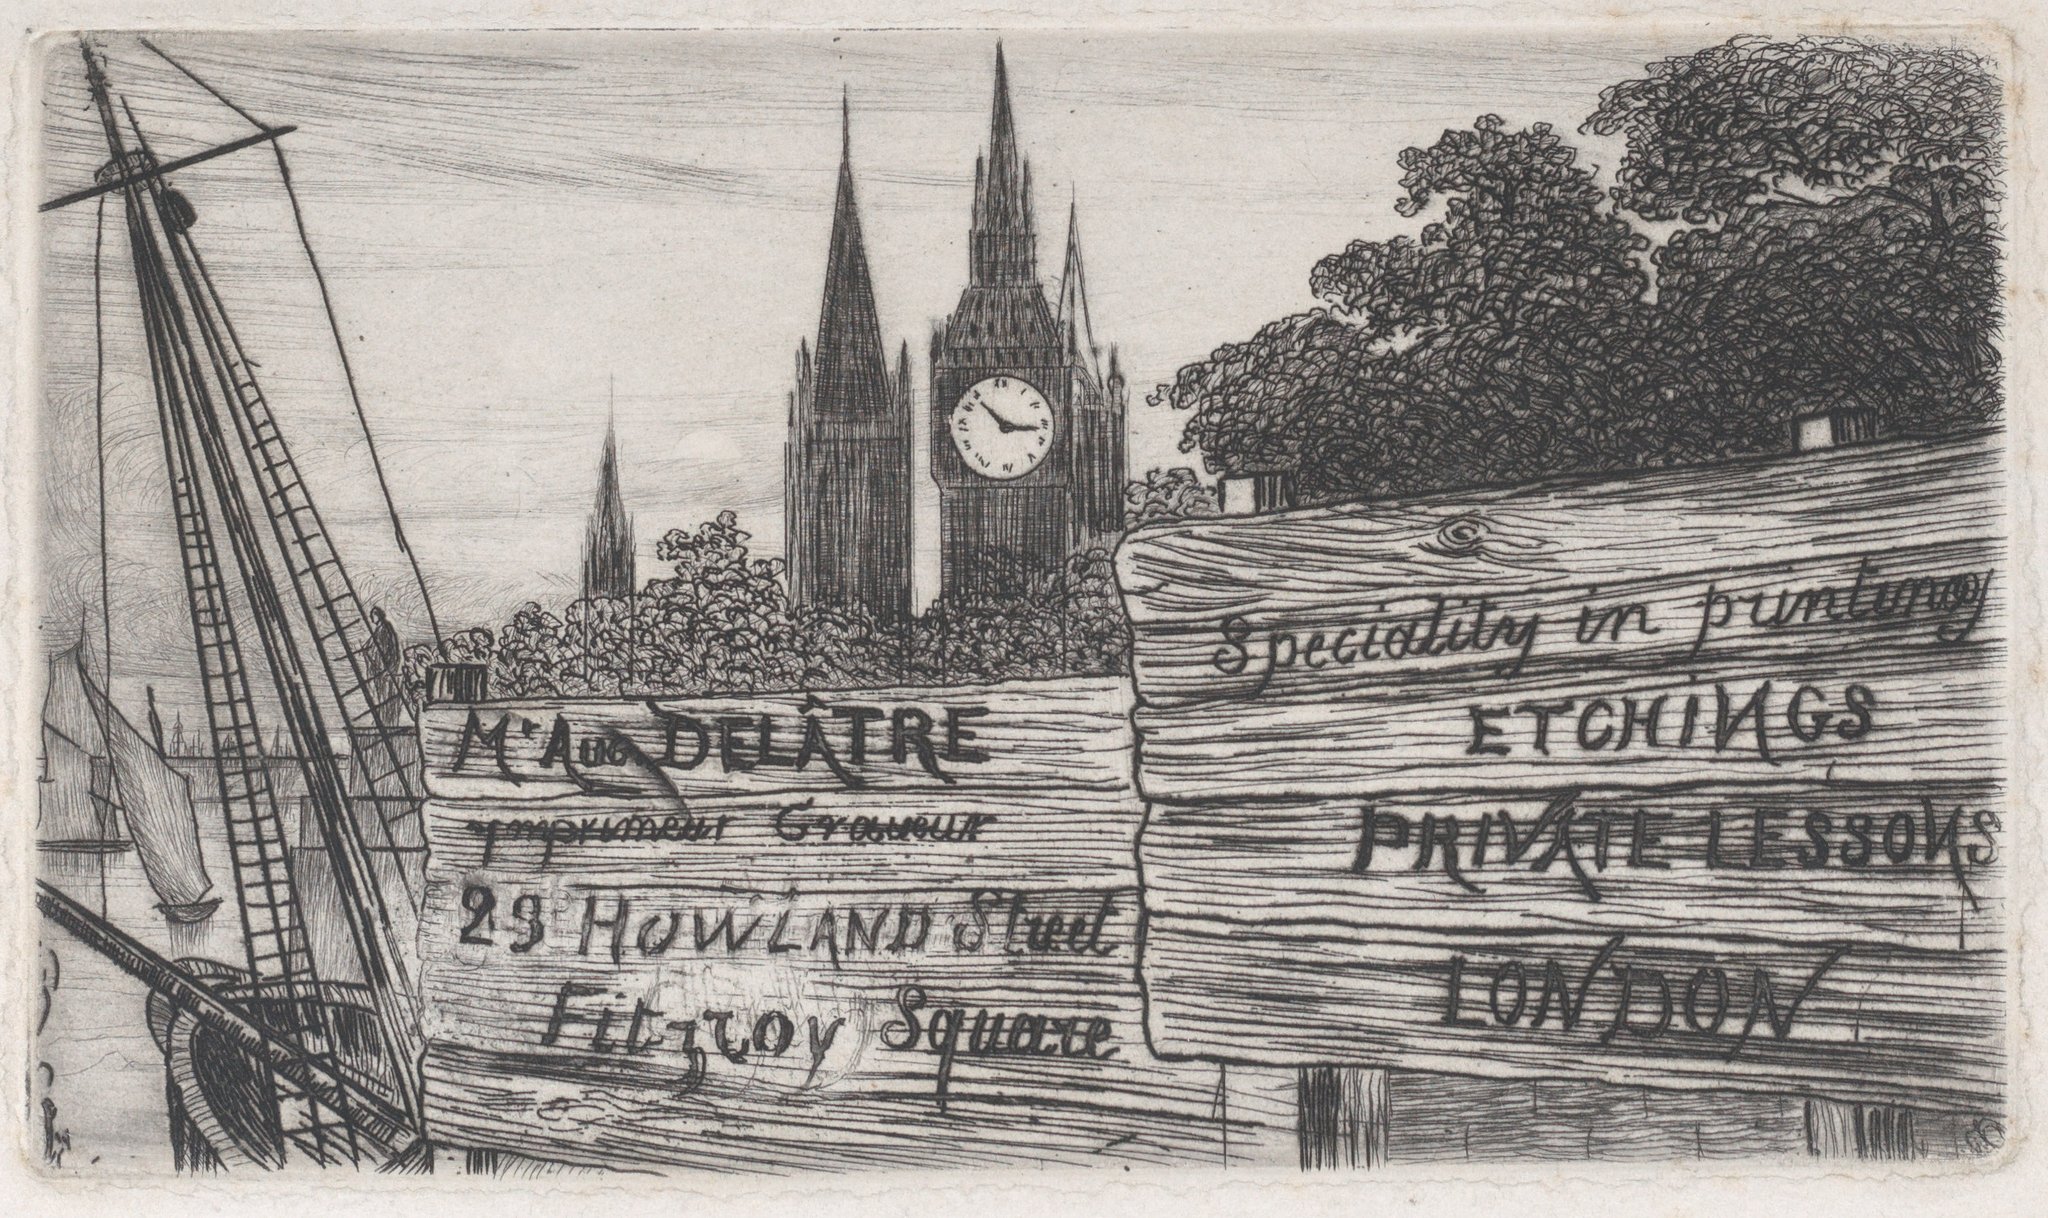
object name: print, trade card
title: Trade card for Auguste Delâtre, publisher and printmaker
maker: auguste delâtre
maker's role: artist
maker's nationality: french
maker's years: 1822-1907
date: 1842-1907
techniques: drypoint